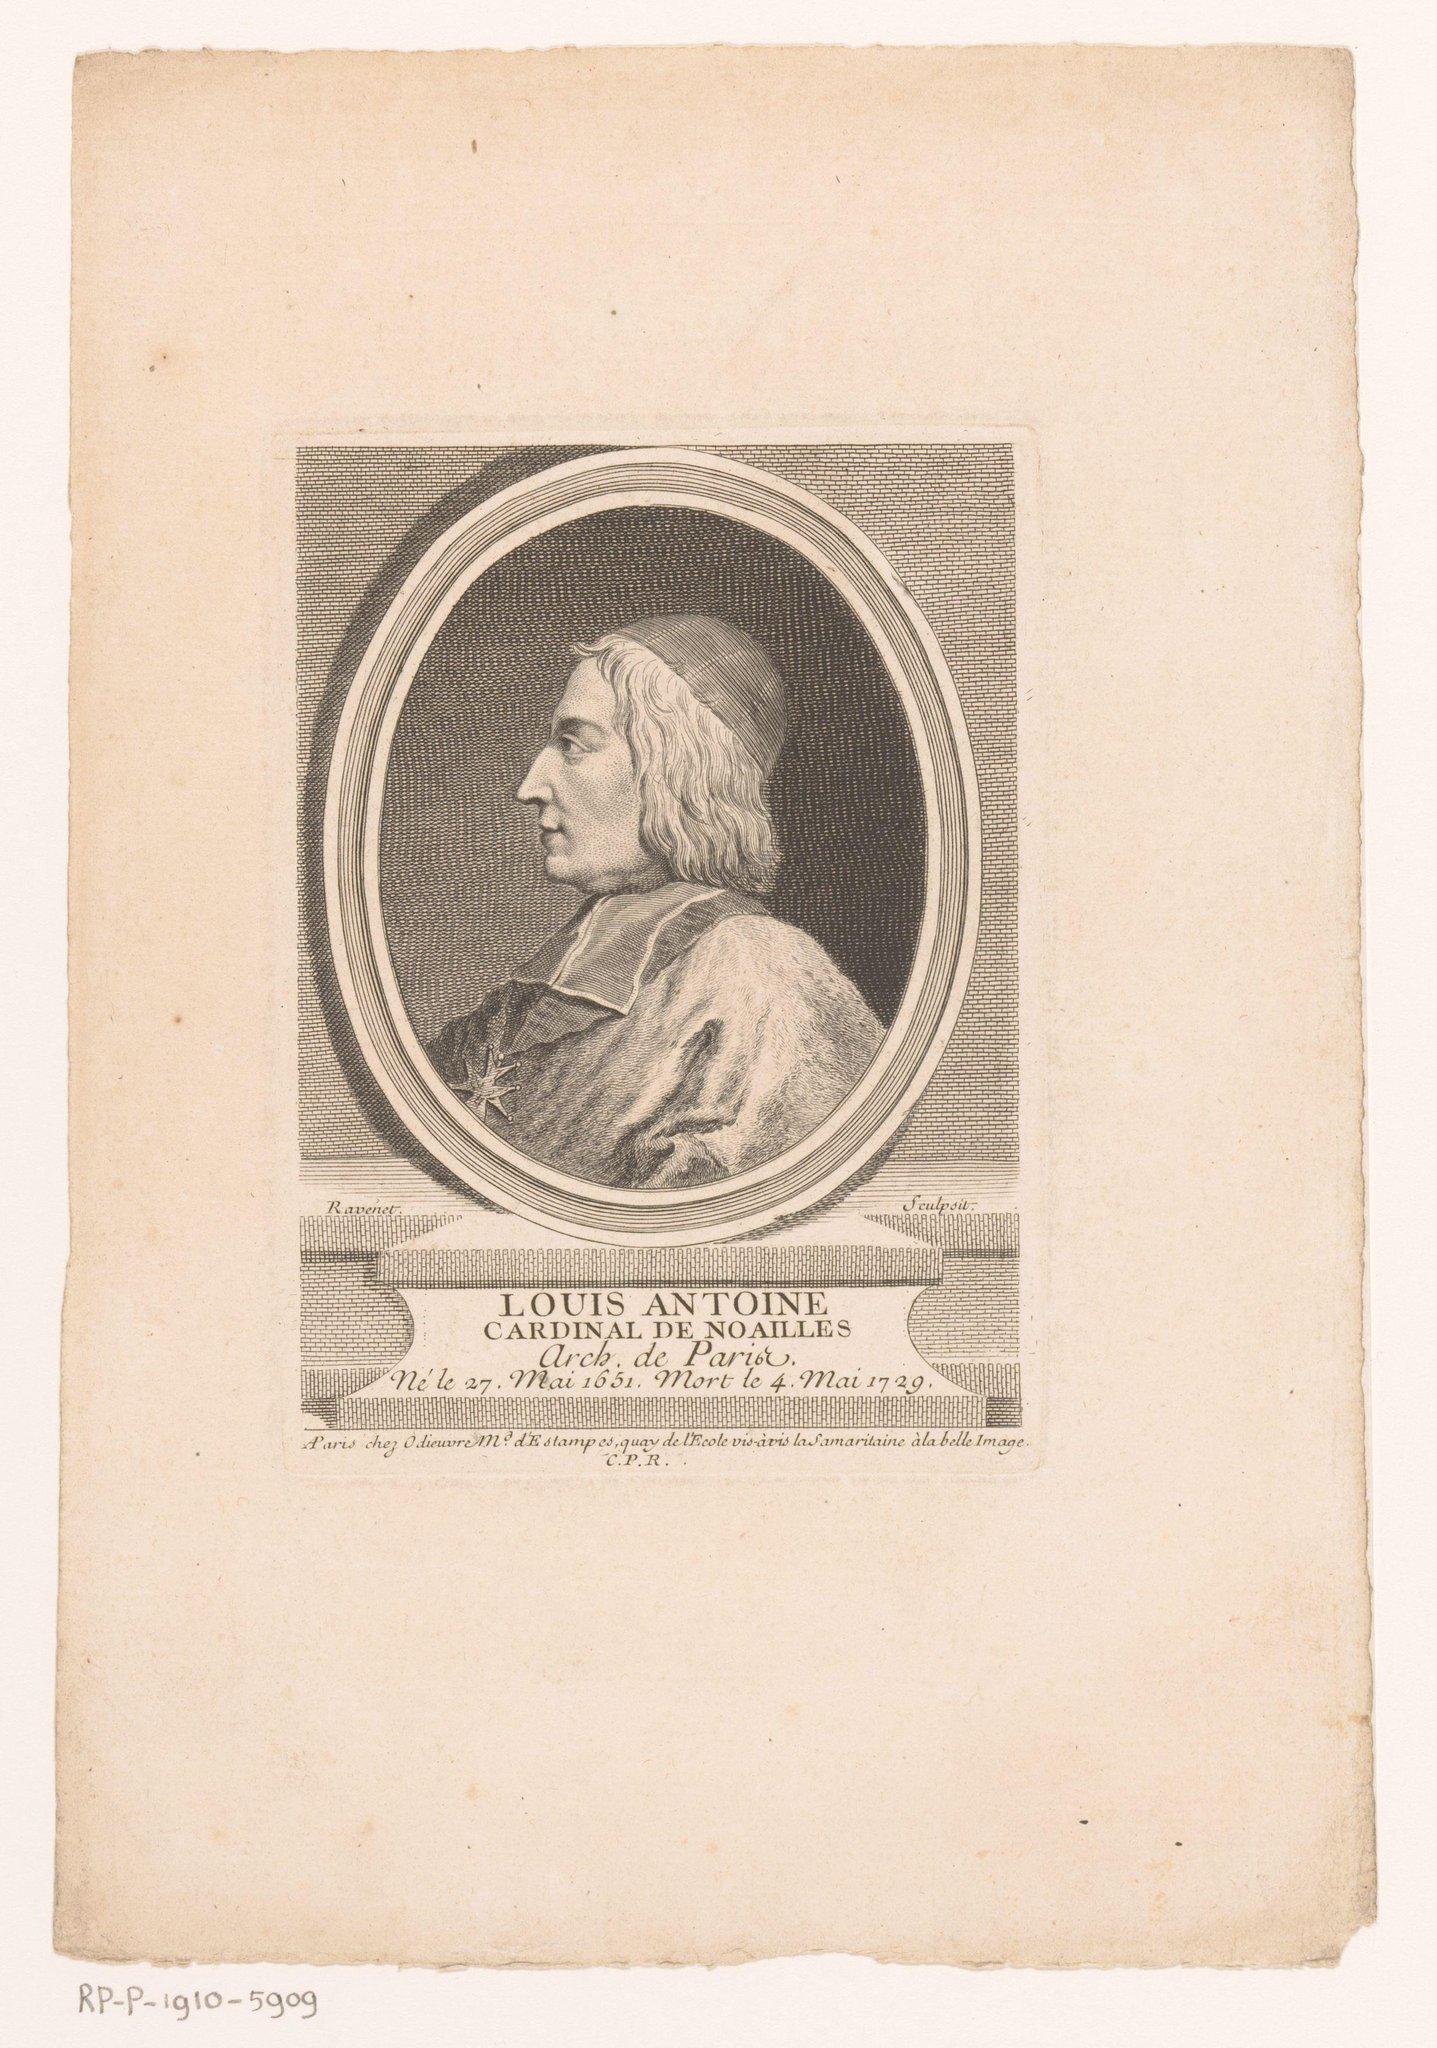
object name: print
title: Louis Antoine Cardinal de Noailles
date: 1729-1756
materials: paper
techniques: engraving, etching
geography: france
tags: paris, priest, louis-antoine de noailles, archbishop, bishop, etc. (roman catholic), historical persons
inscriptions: collector's mark: Lugt 2228